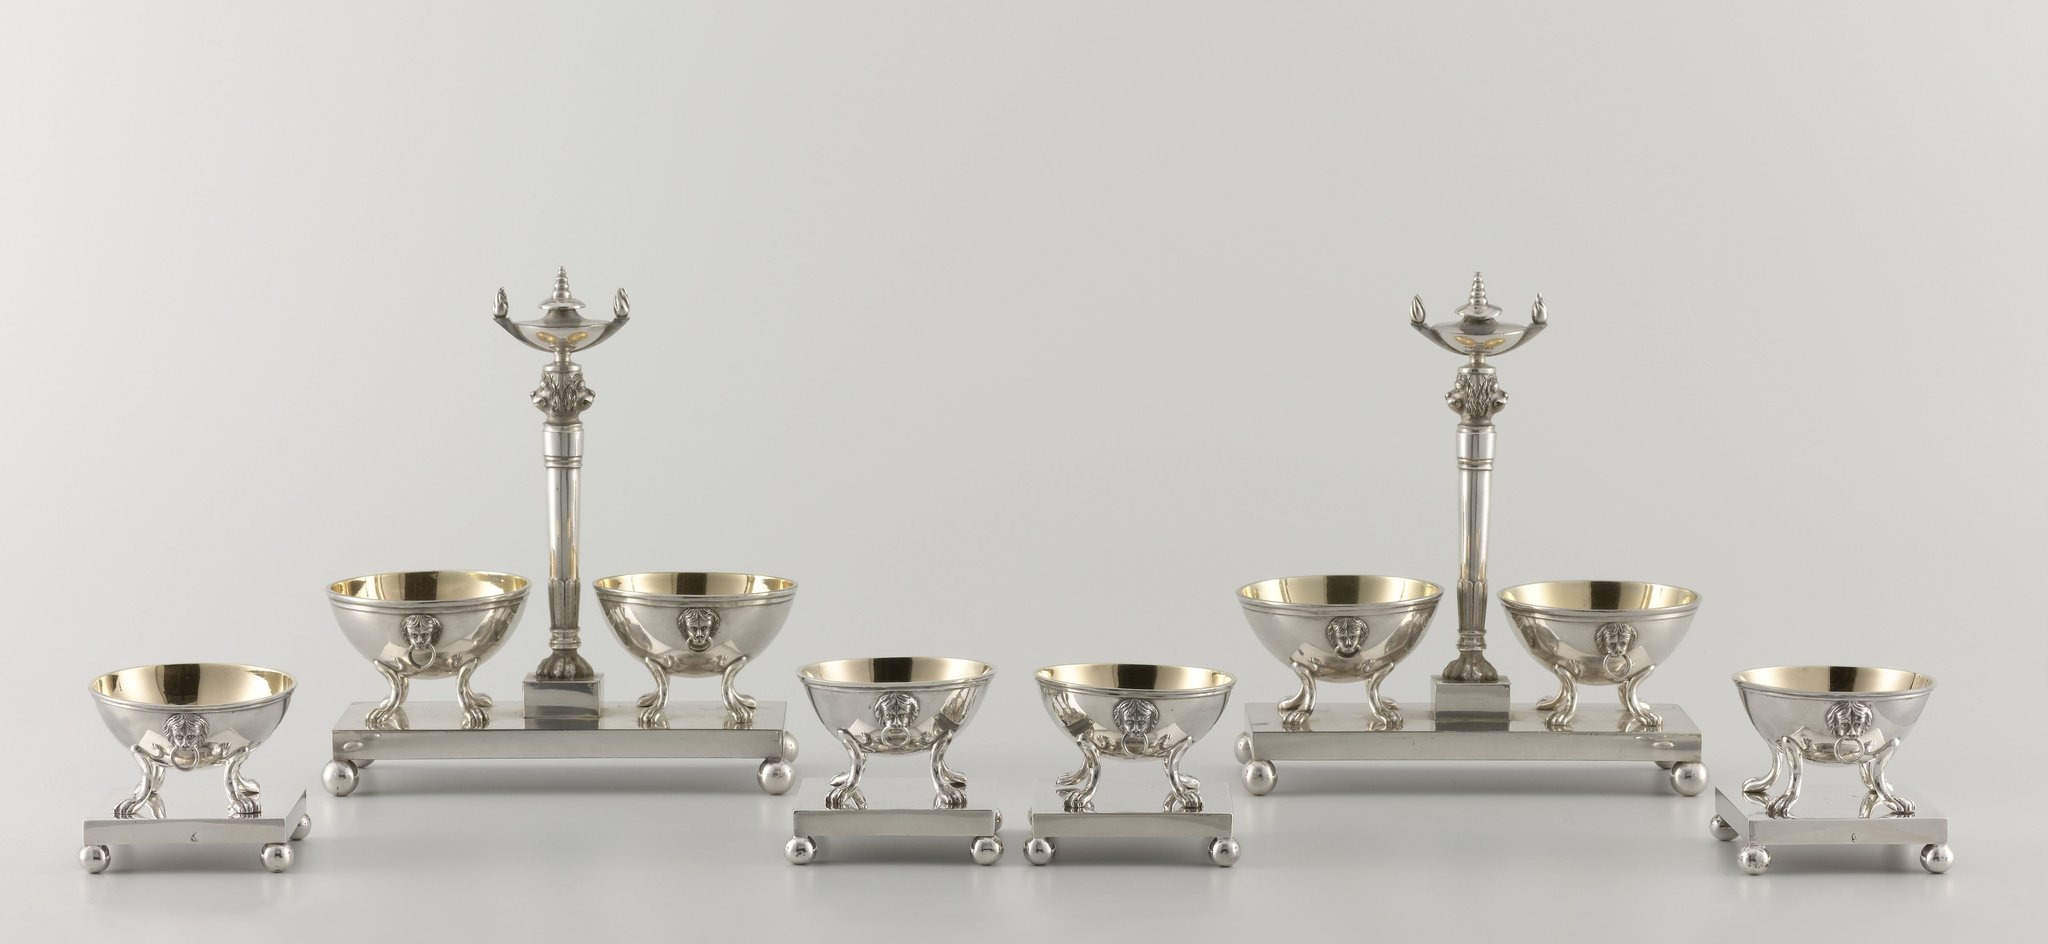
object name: salt condiment vessel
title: Een van vier zoutvaten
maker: francois marcus simons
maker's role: silversmith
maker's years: 1750-1828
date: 1803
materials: silver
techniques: casting, metalworking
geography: the hague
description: Dinner service. Silver, parcel gilt. The Hague, 1803 and 1804, by François Simons. The Government of the Batavian Republic presented this service to I.J.A. Gogel (1765 - 1821) in 1804 in recognition of his financial services to the country. Gogel was a prominent patriot, minister of finance under King Louis Napoleon and subsequently financial advisor to King